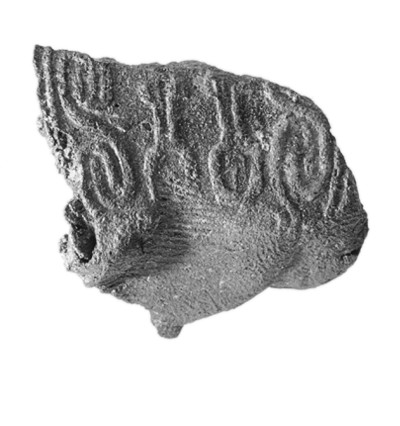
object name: sealing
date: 1981-1640 BCE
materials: mud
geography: egypt